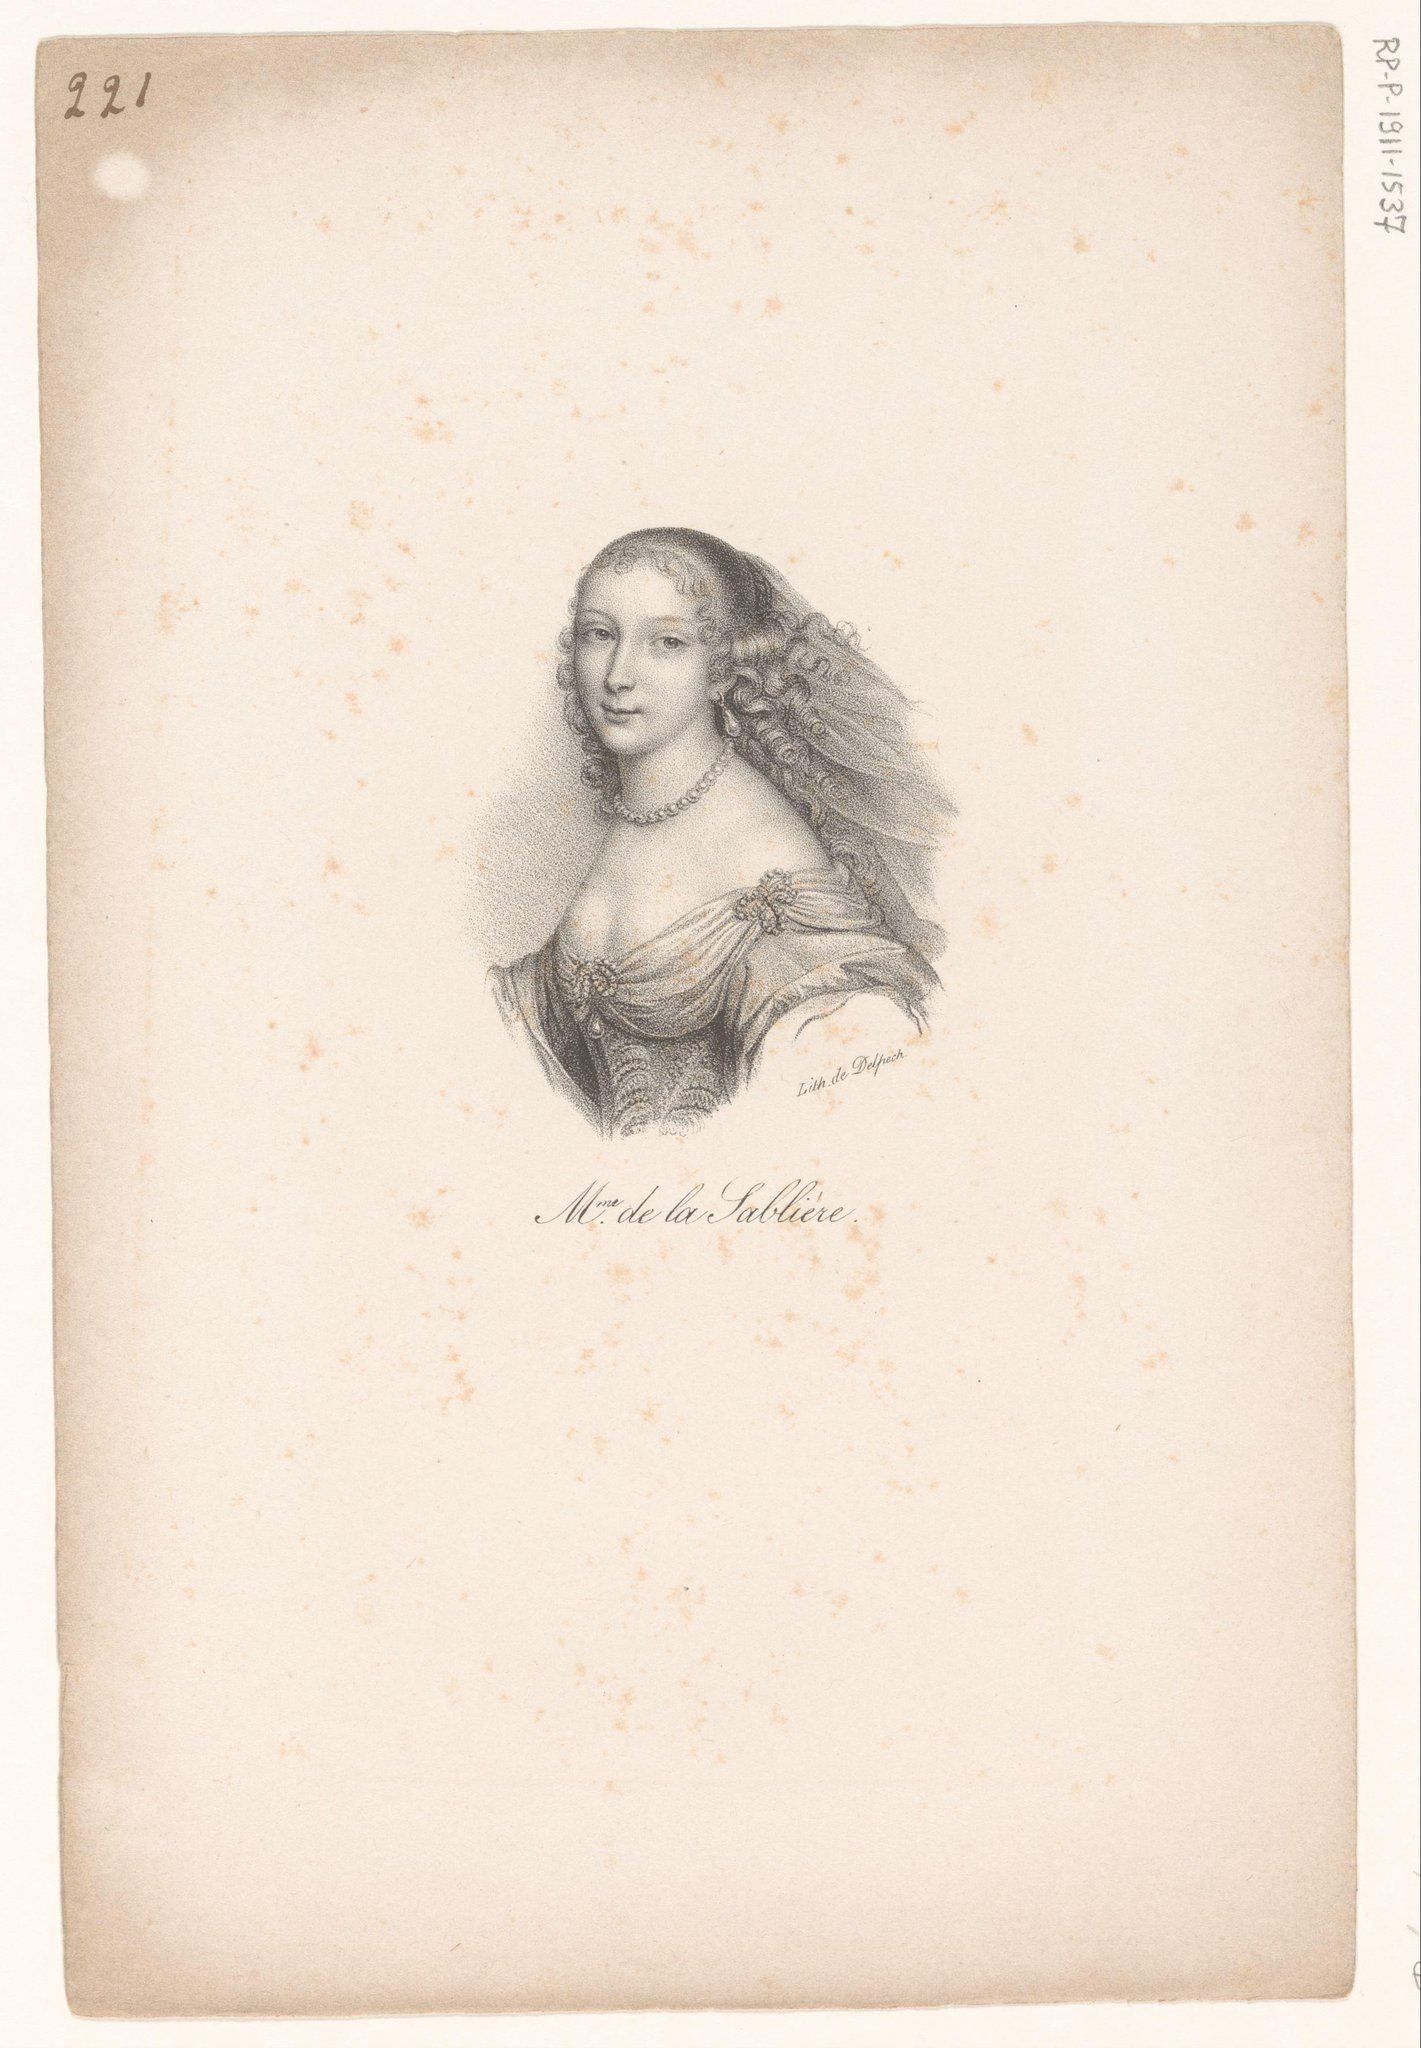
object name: print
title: Portret van Marguerite Hessein de La Sablière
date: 1818-1842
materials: paper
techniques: lithograph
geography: paris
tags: historical persons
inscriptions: collector's mark: Lugt 2228a